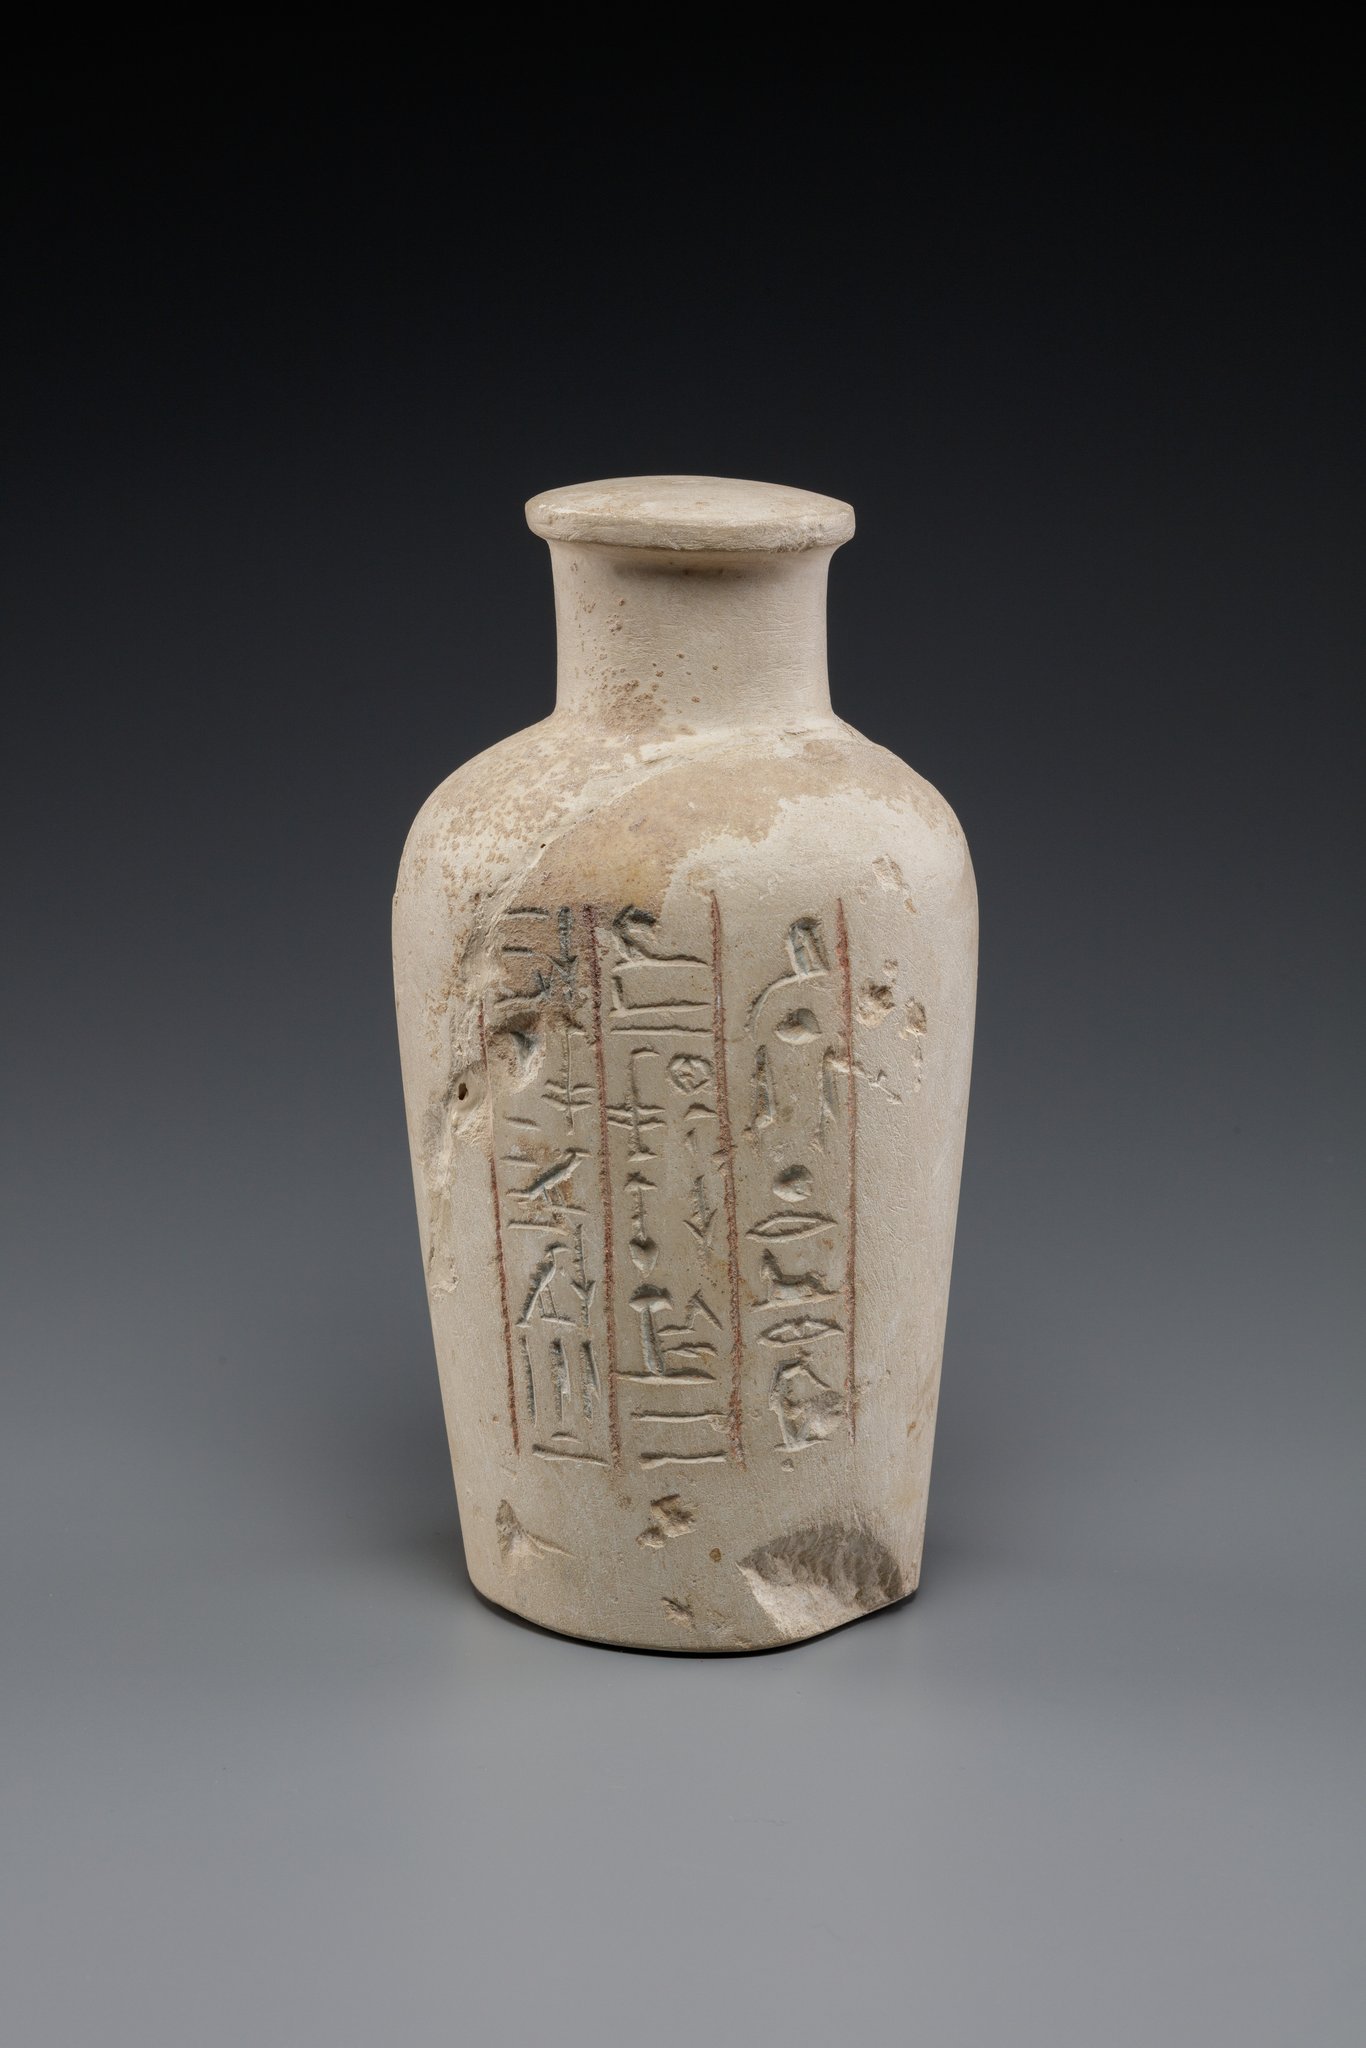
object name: model, jug, senetnay, sennefer, kv 42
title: Dummy Jar Inscribed for Sennefer and Senetnay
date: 1427-1400 BCE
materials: limestone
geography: egypt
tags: hieroglyphs